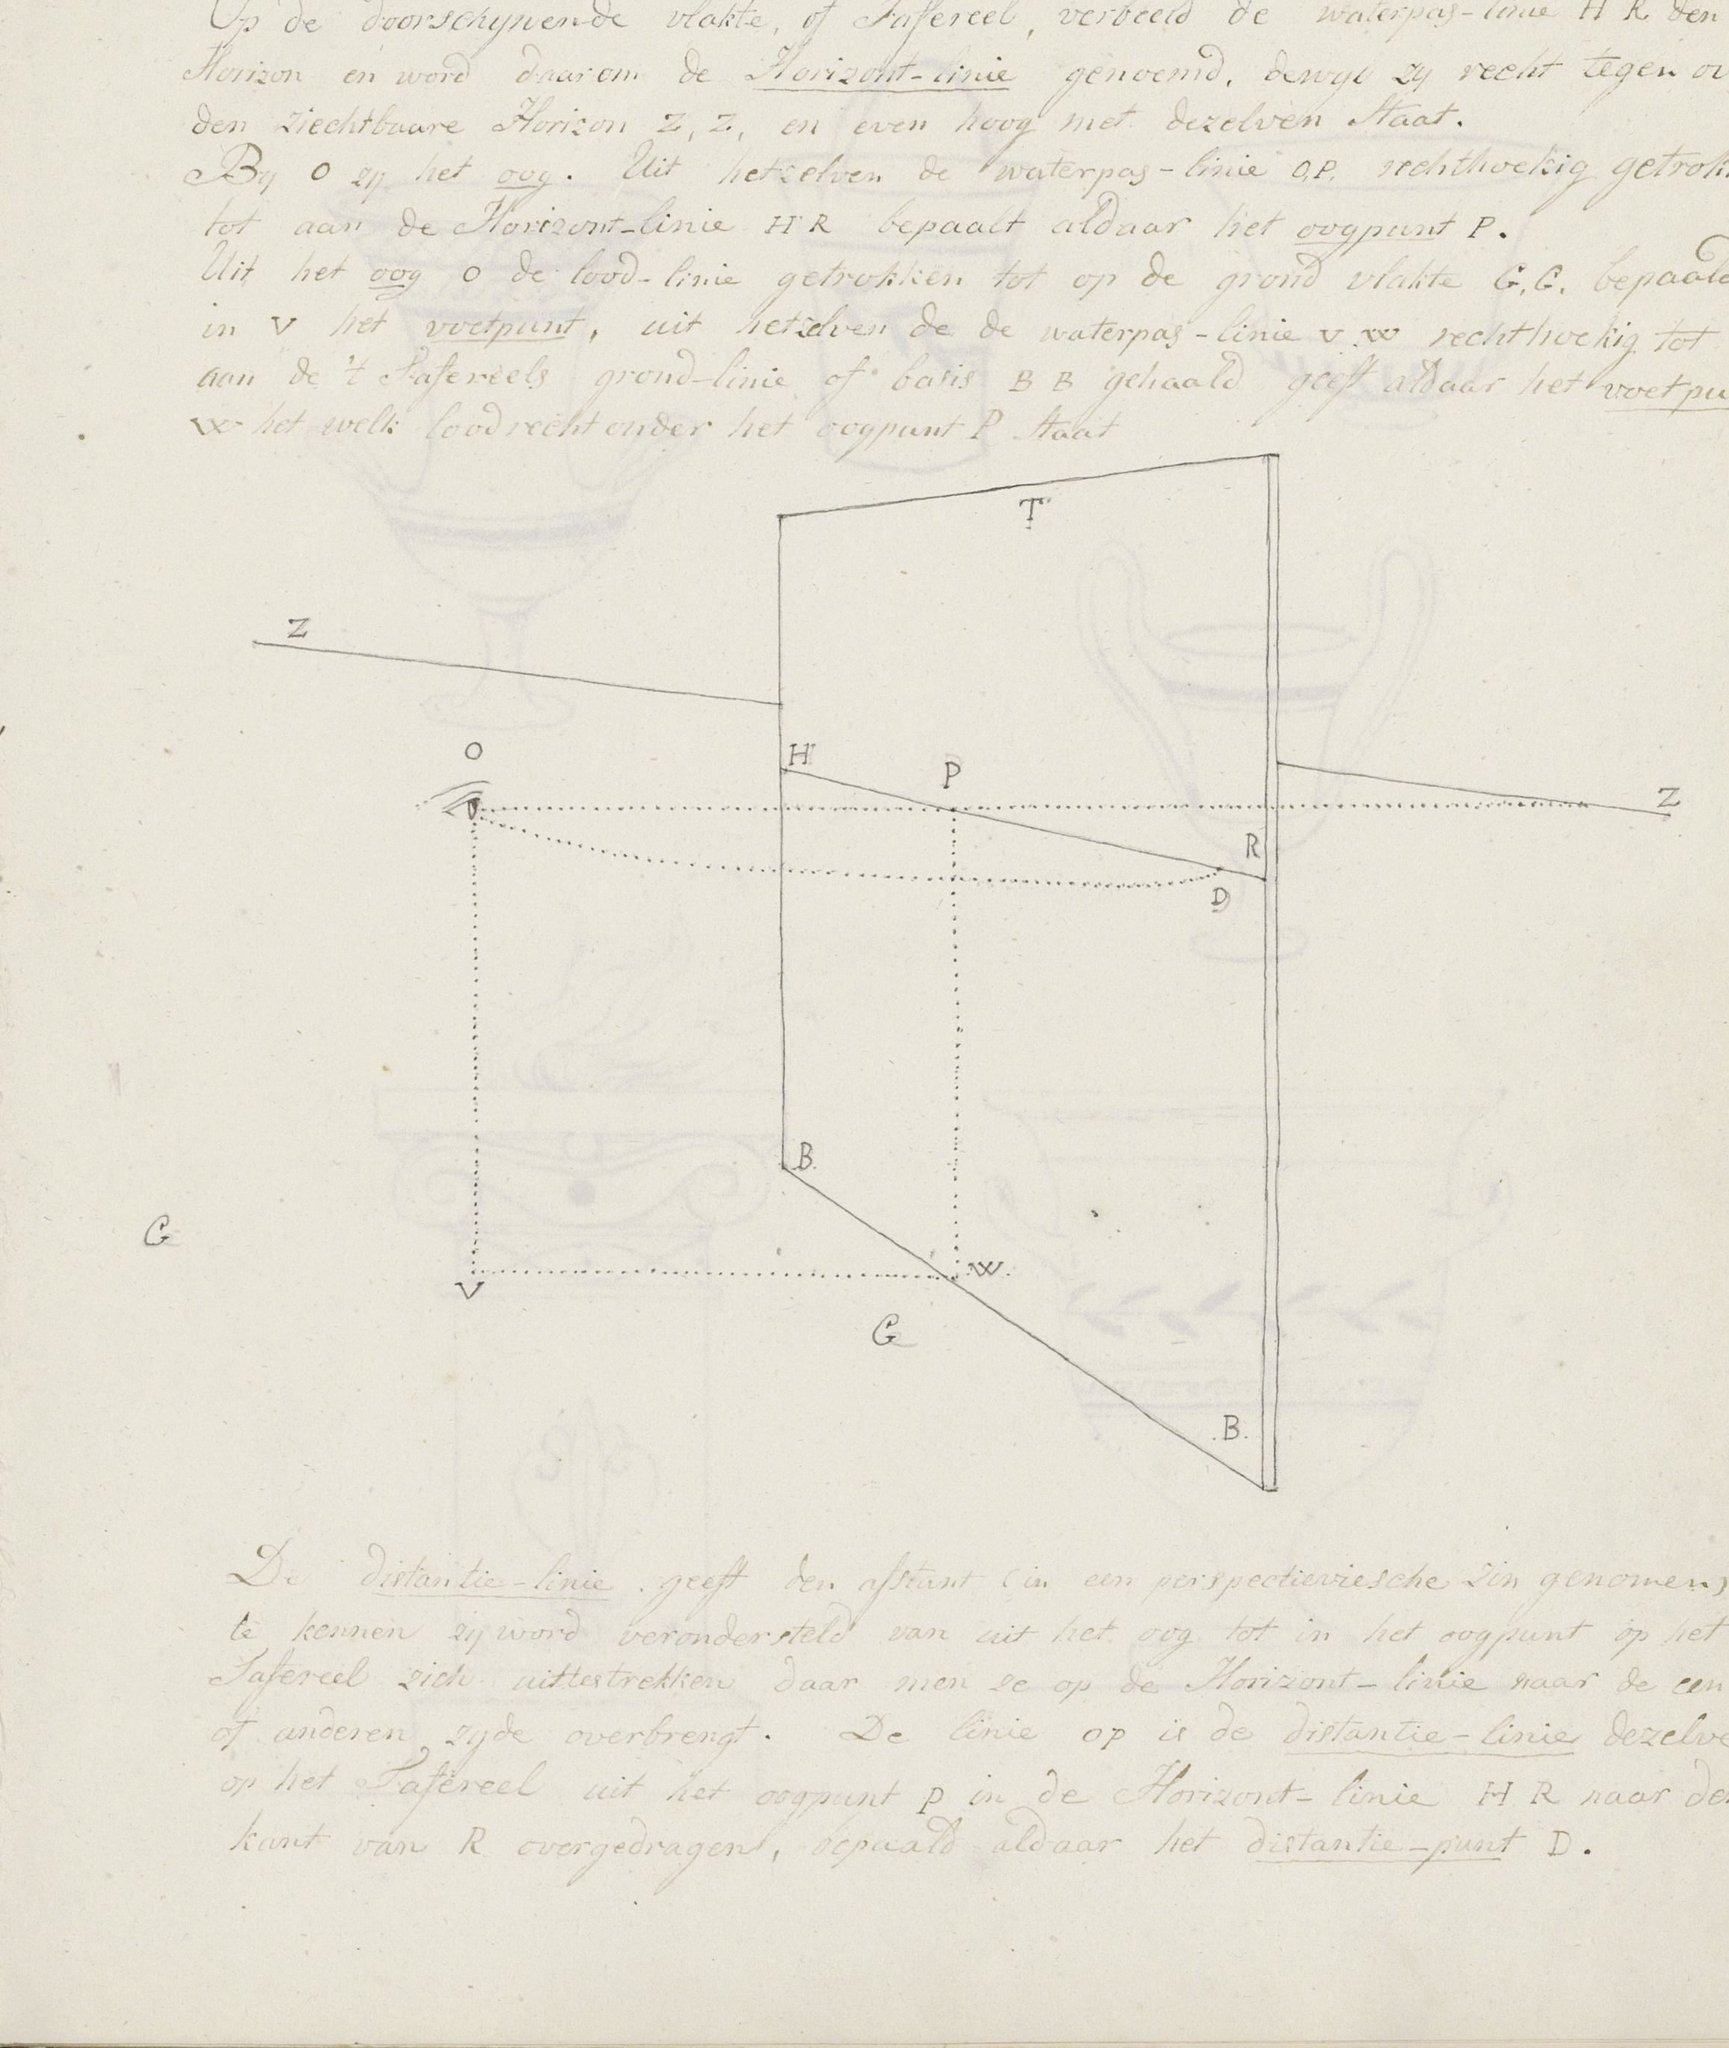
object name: sketchbook leaf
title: Perspectiefoefening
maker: jonkvrouw elisabeth kemper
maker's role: draughtsman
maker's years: 1799-1871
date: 1815-1852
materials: ink, paper, pencil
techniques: pen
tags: mathematical perspective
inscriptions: annotation: ‘[...]’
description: Blad 4 recto uit een schetsboek met 94 bladen.